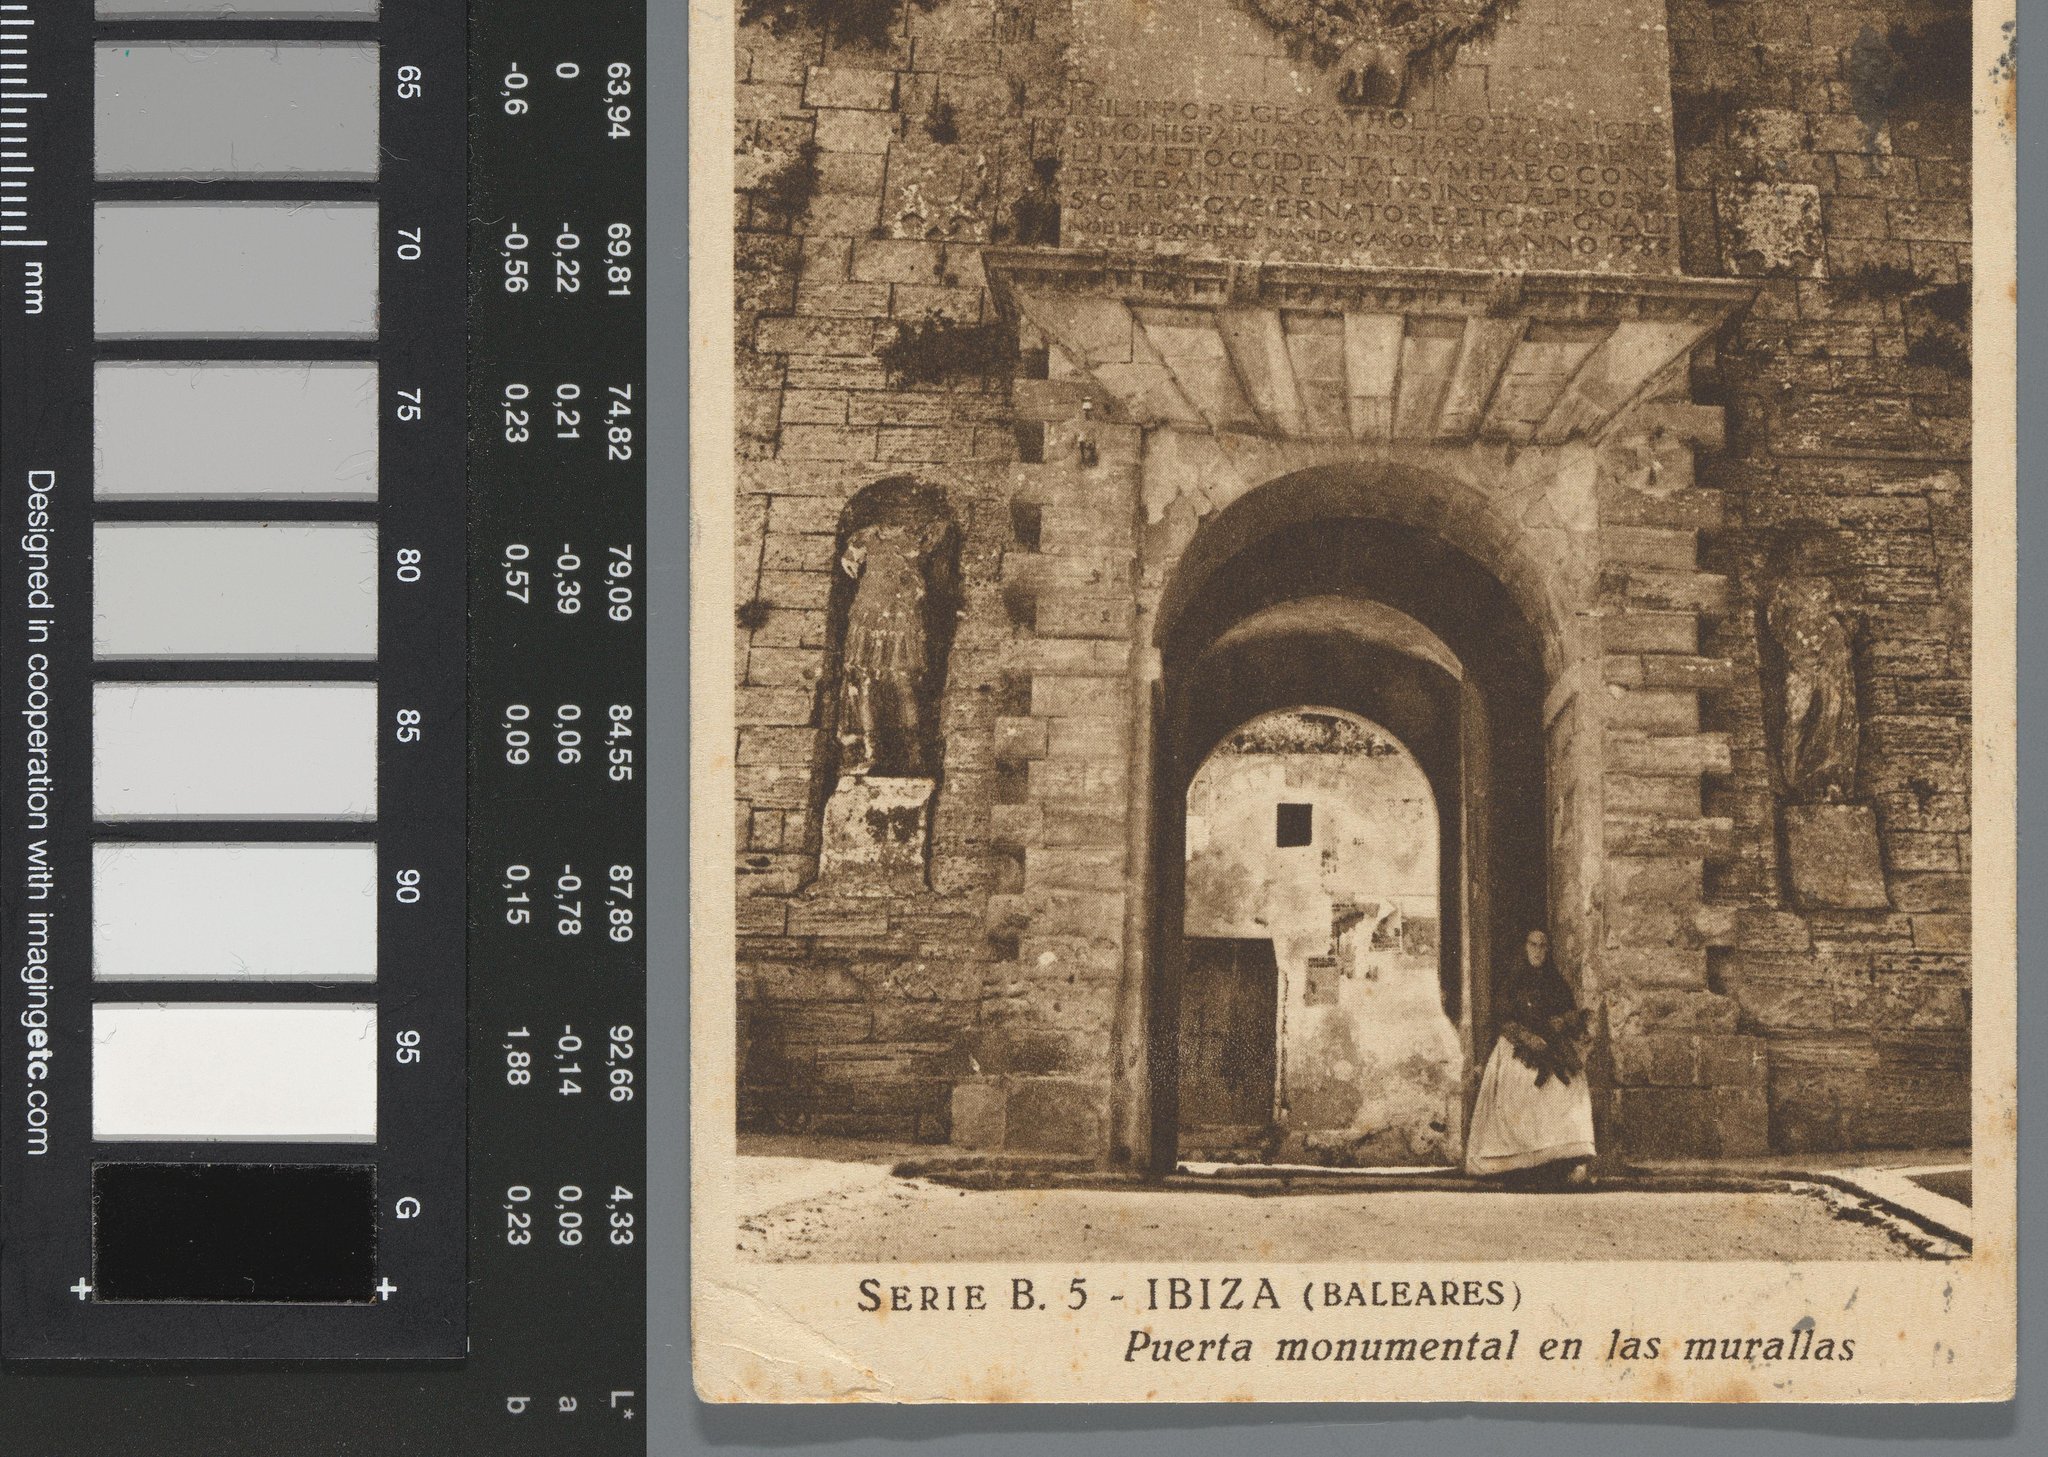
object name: postcard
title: Puerta monumental en las murallas, Ibiza, Baleares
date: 1920-1950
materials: photographic support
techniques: rotogravure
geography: ibiza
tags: ibiza